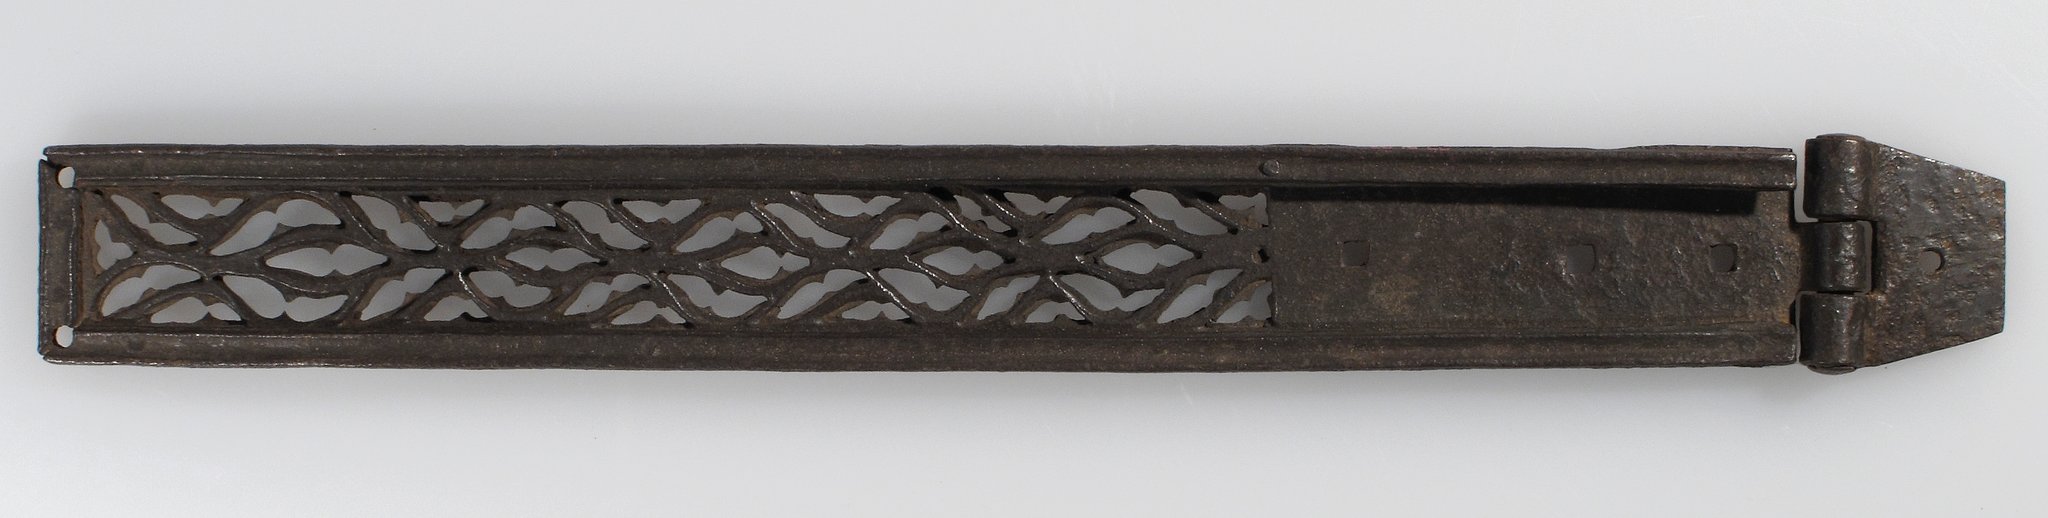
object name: strap hinge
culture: european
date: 1401-1600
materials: iron